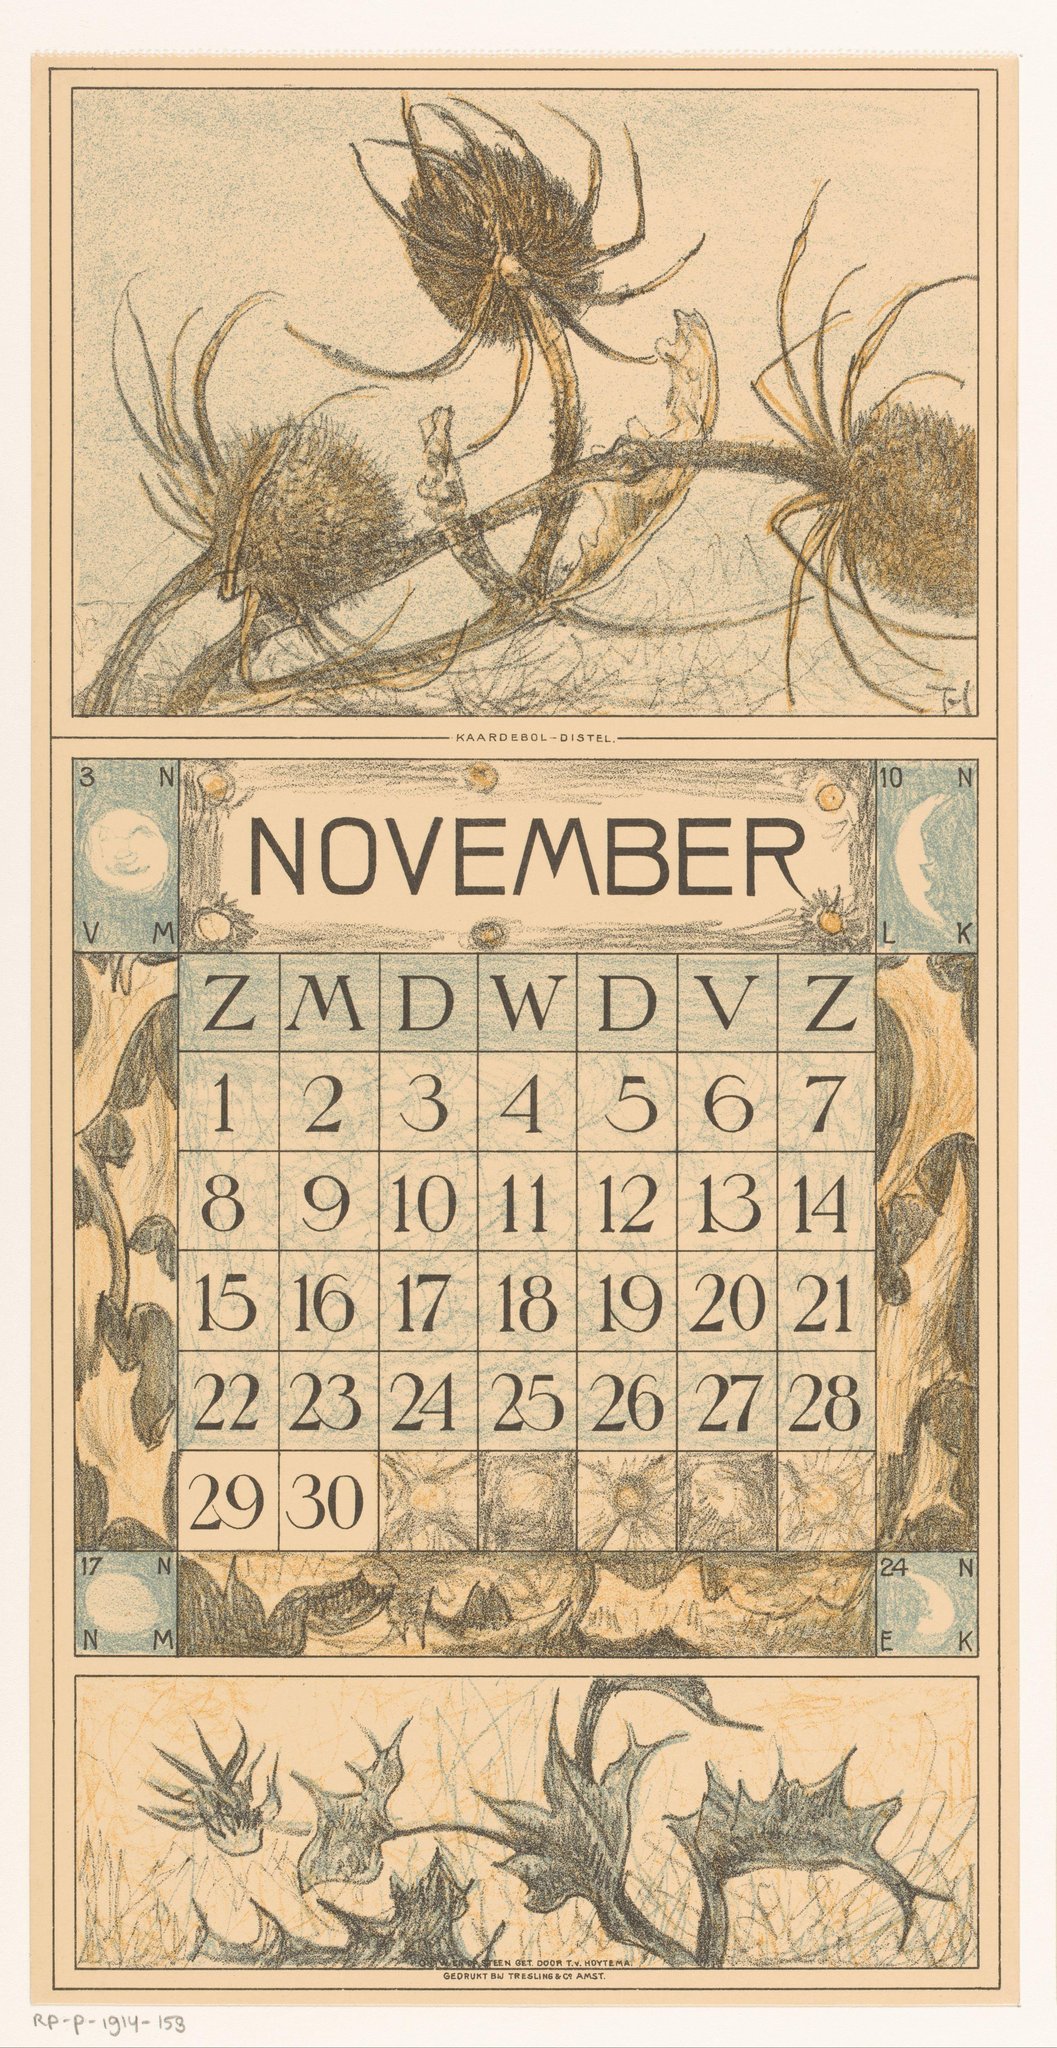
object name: print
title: Kaardebol-distel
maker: theo van hoytema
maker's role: draughtsman, painter, print maker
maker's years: 1863-1917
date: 1913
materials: paper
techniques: lithograph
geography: amsterdam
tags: lunar year, november ~ other concepts, plants and herbs: thistle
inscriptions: collector's mark: Lugt 2228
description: In de hoeken de standen van de maan op vier dagen. Bovenaan het blad een scheurlijn.